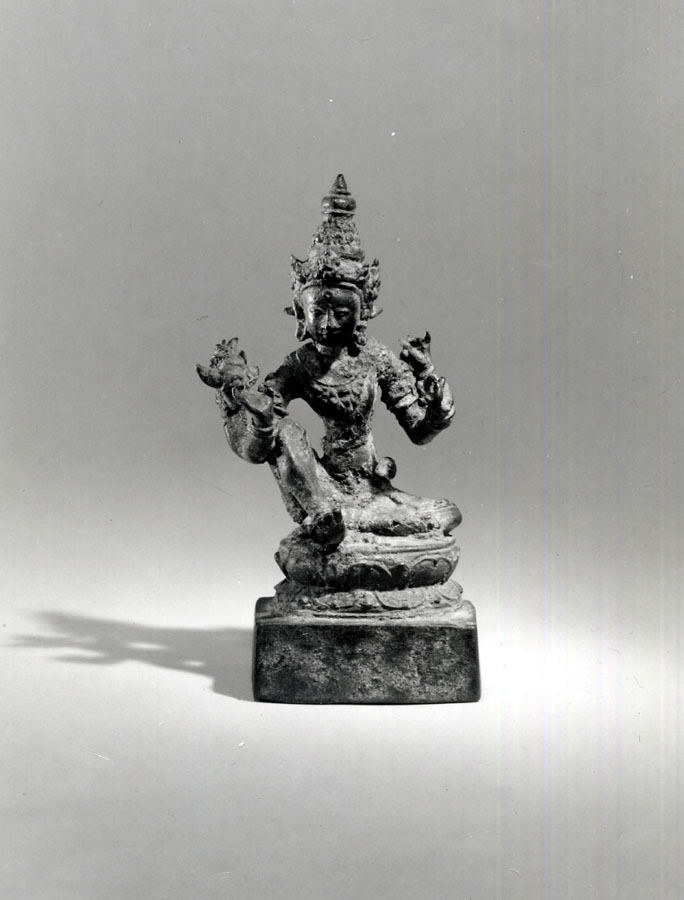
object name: figurine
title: Seated Bodhisattva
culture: indonesian, javanese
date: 1101-1200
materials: bronze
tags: buddhism,bodhisattvas